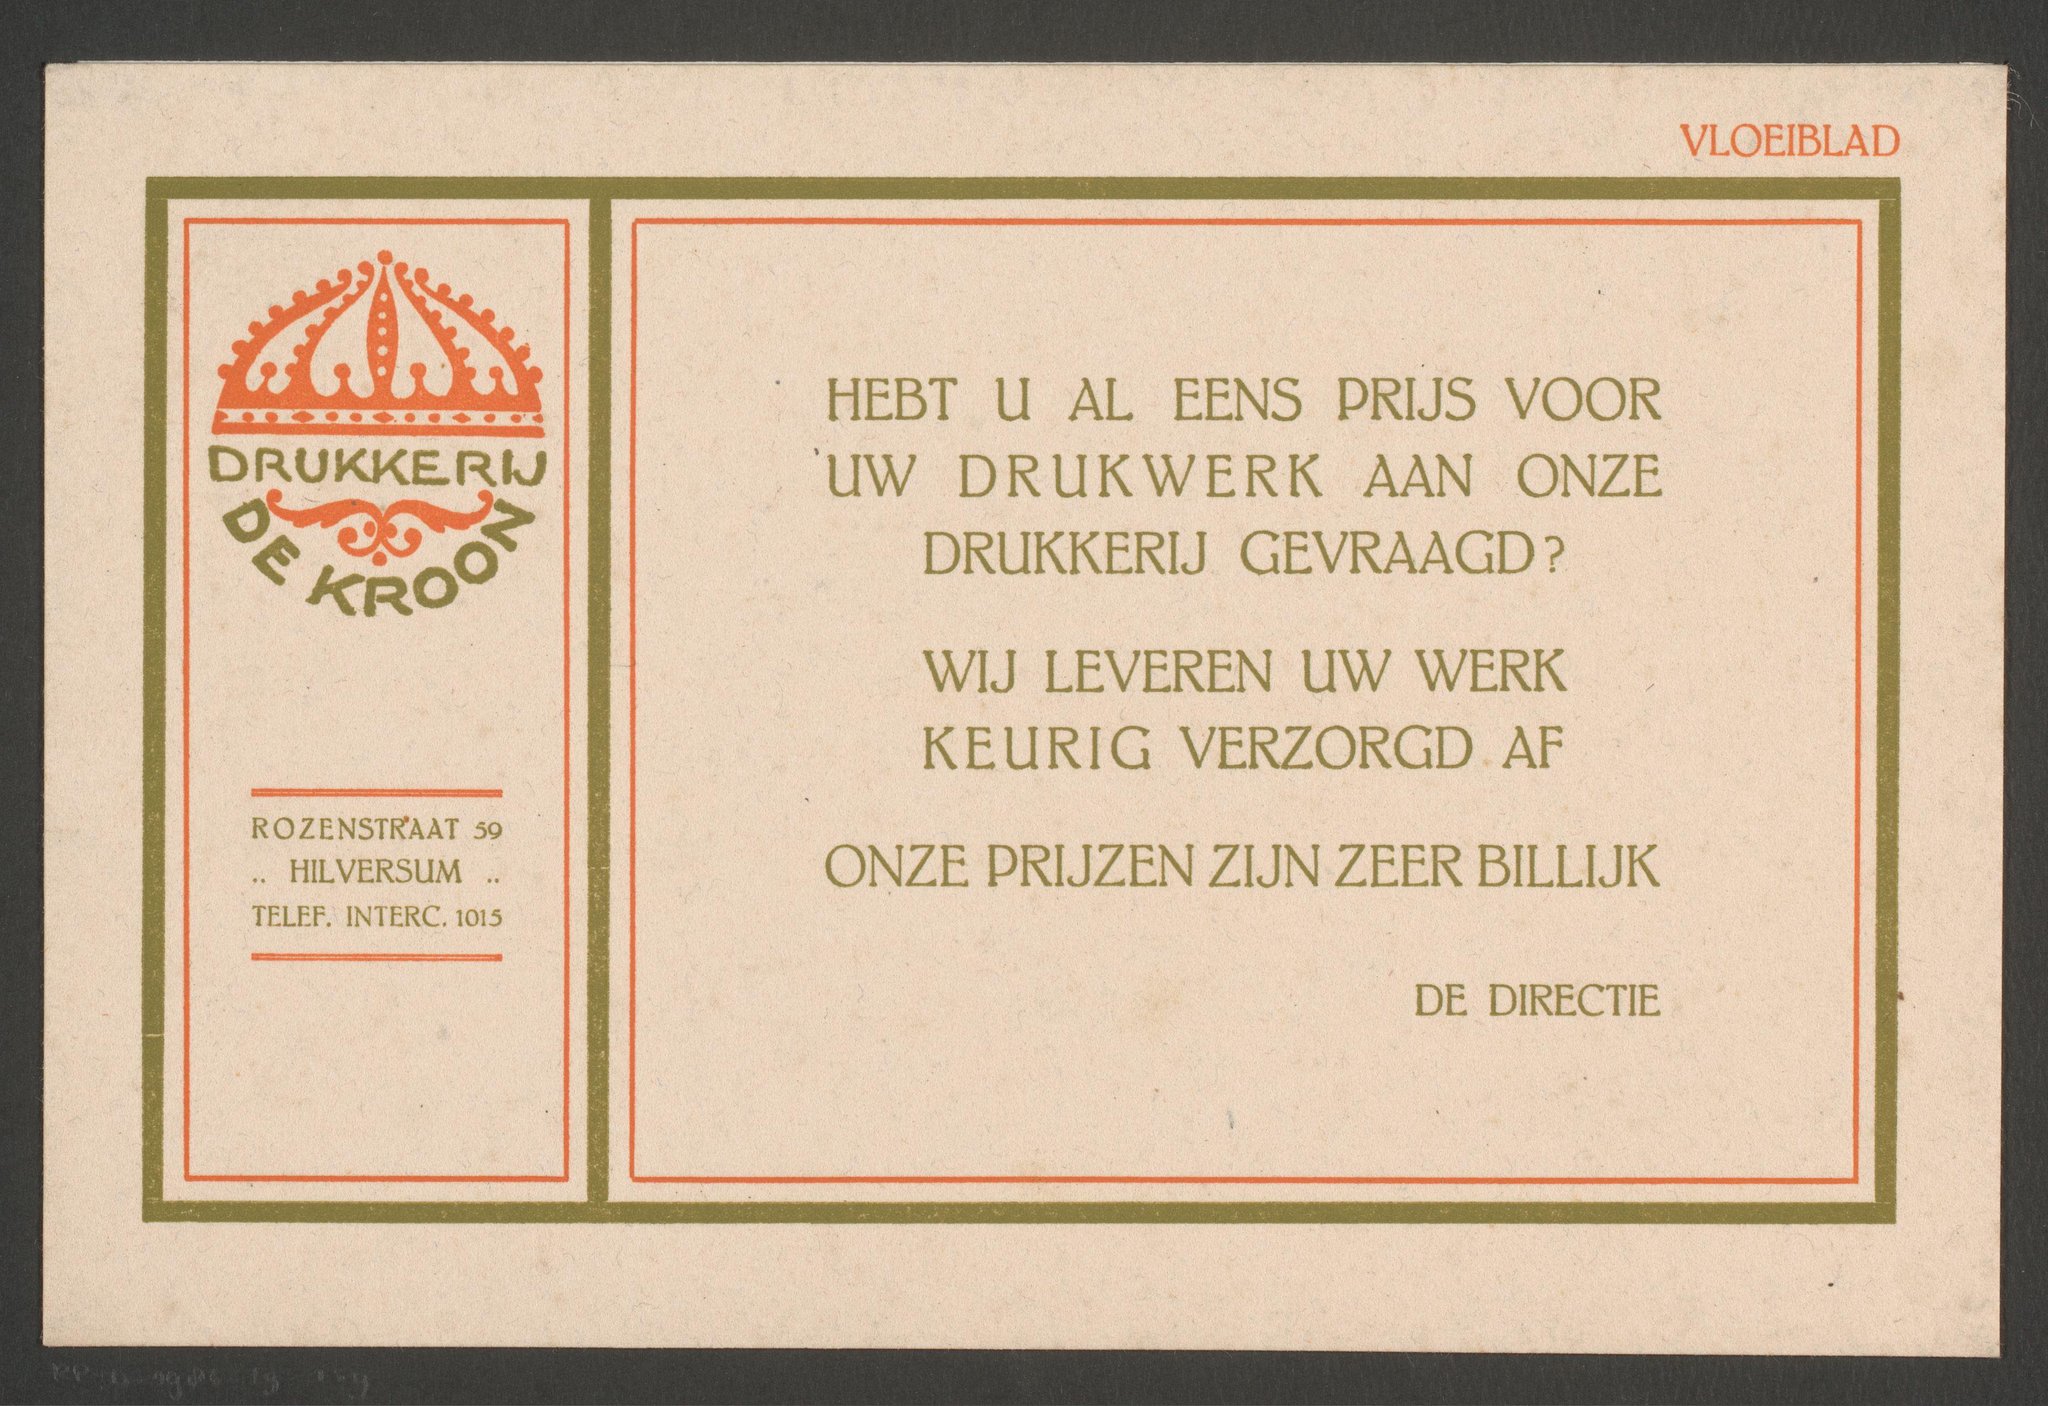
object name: print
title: Advertentie van drukkerij De Kroon te Hilversum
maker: Anonymous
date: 1884-1952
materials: paper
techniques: relief print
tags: crown (symbol of sovereignty)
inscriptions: collector's mark: ‘R:MVS.’